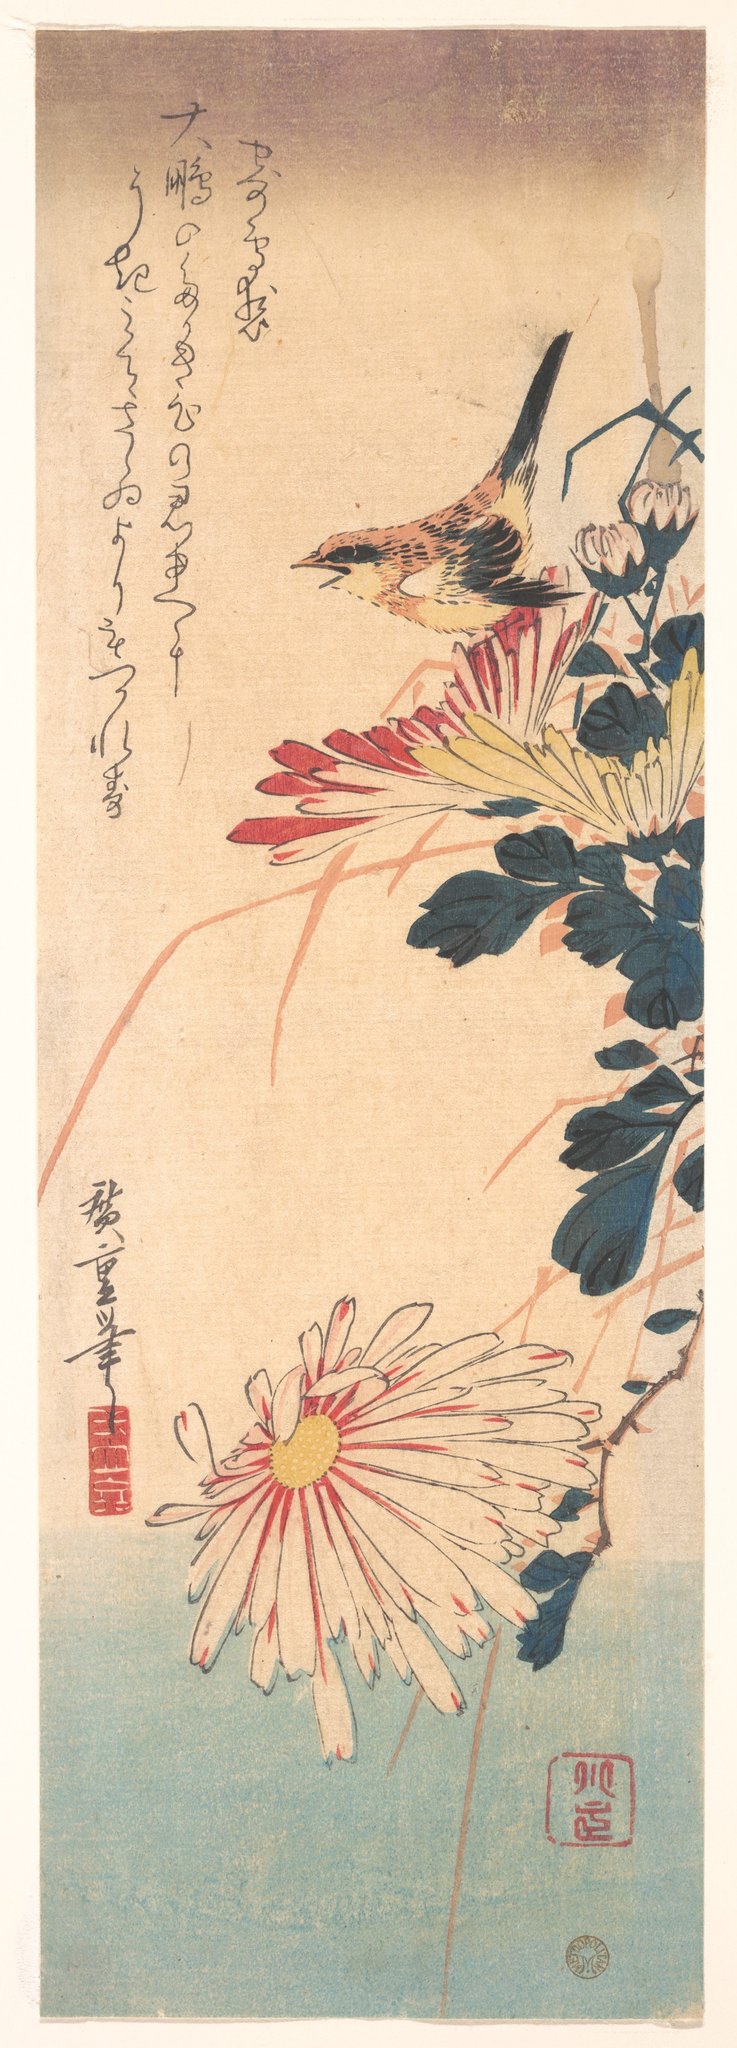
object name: print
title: A Wren and Chrysanthemums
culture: japanese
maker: utagawa hiroshige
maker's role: artist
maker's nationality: japanese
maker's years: 1797-1858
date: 1830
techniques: woodblock print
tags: birds,flowers